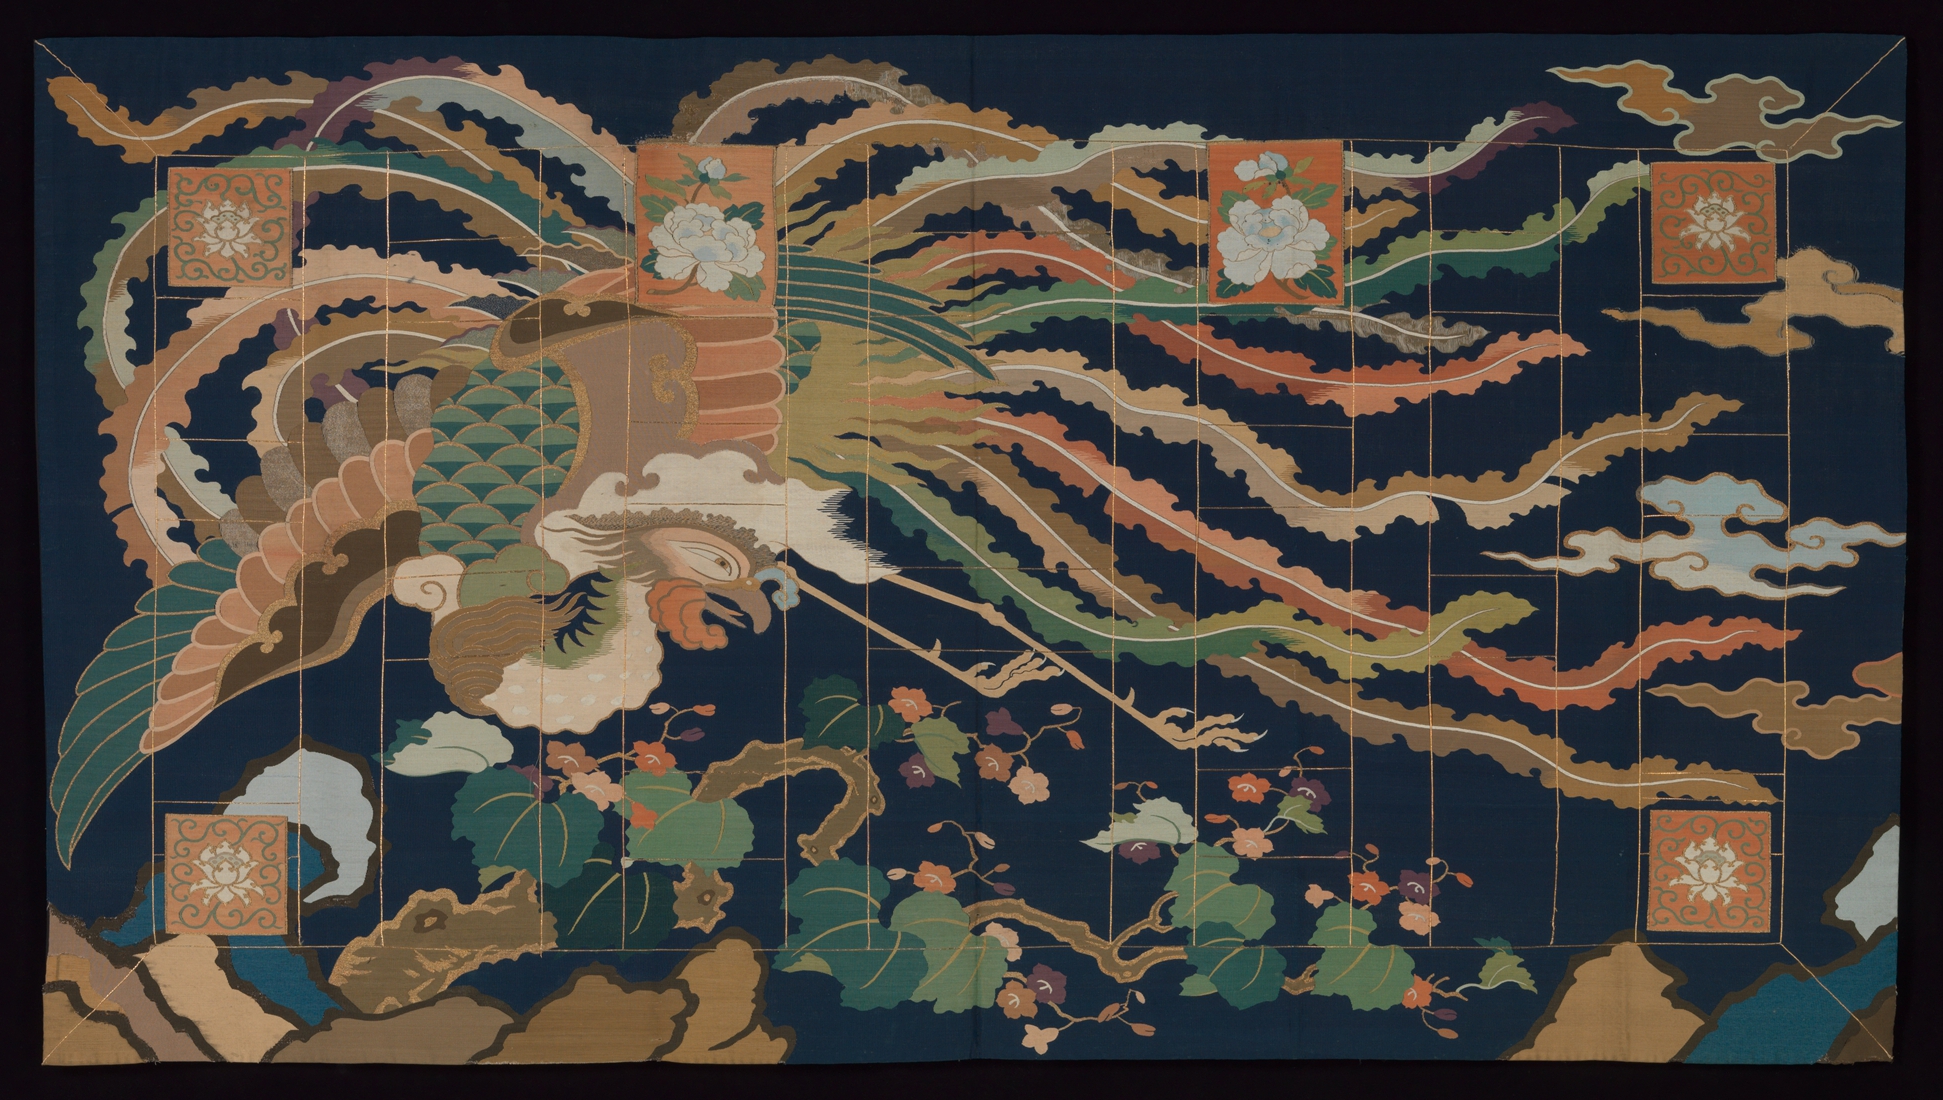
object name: robe, priest's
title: Buddhist Priest's Vestment (Kesa) with Phoenix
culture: japanese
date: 1801-1900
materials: metal thread, silk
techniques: tapestry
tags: phoenix